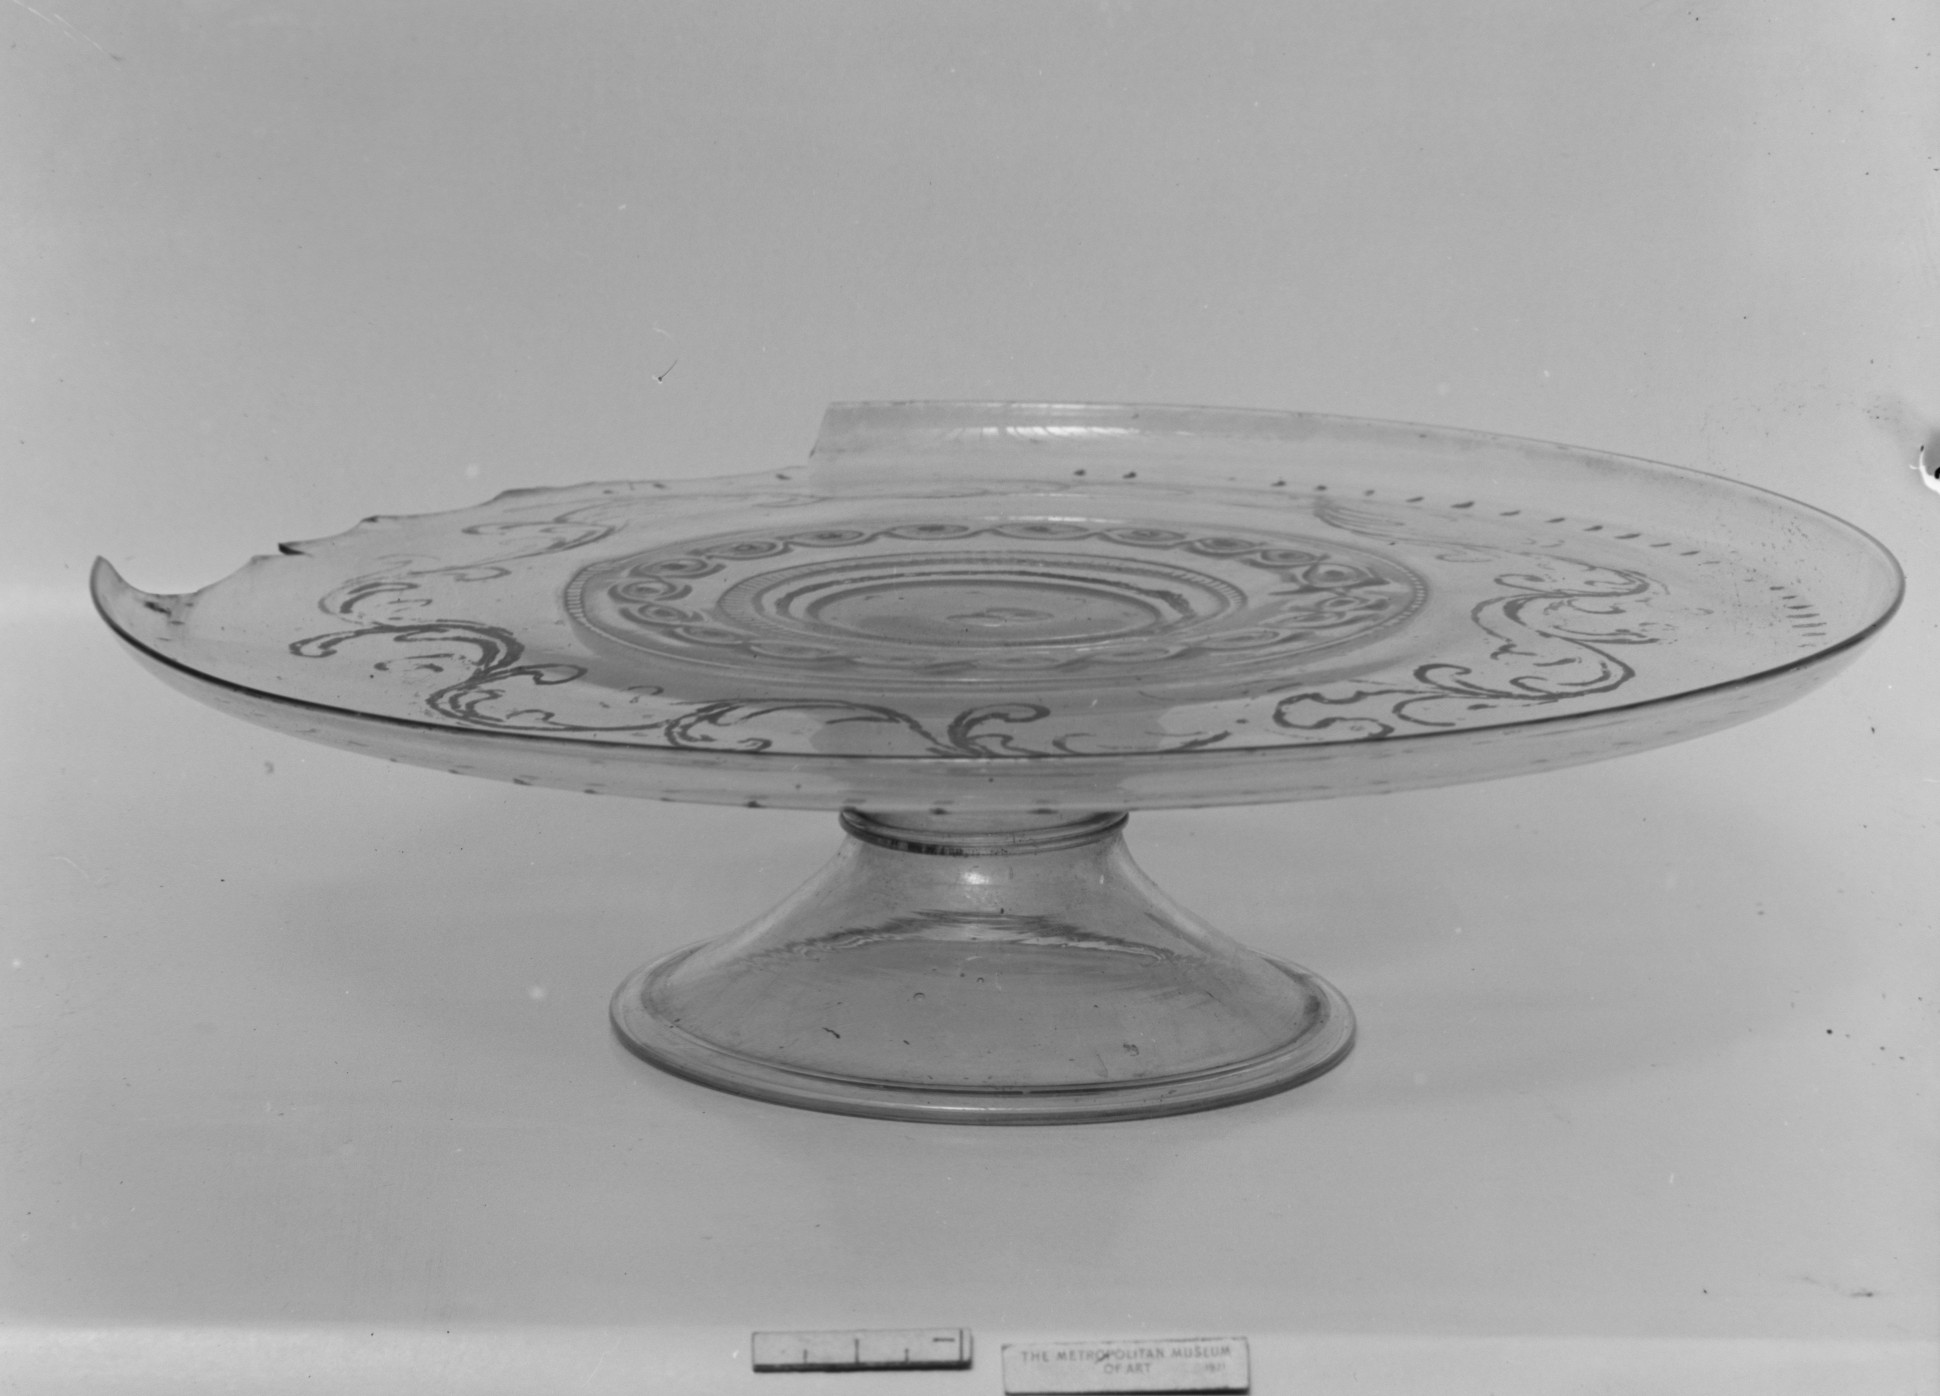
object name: tazza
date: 1601-1633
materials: glass